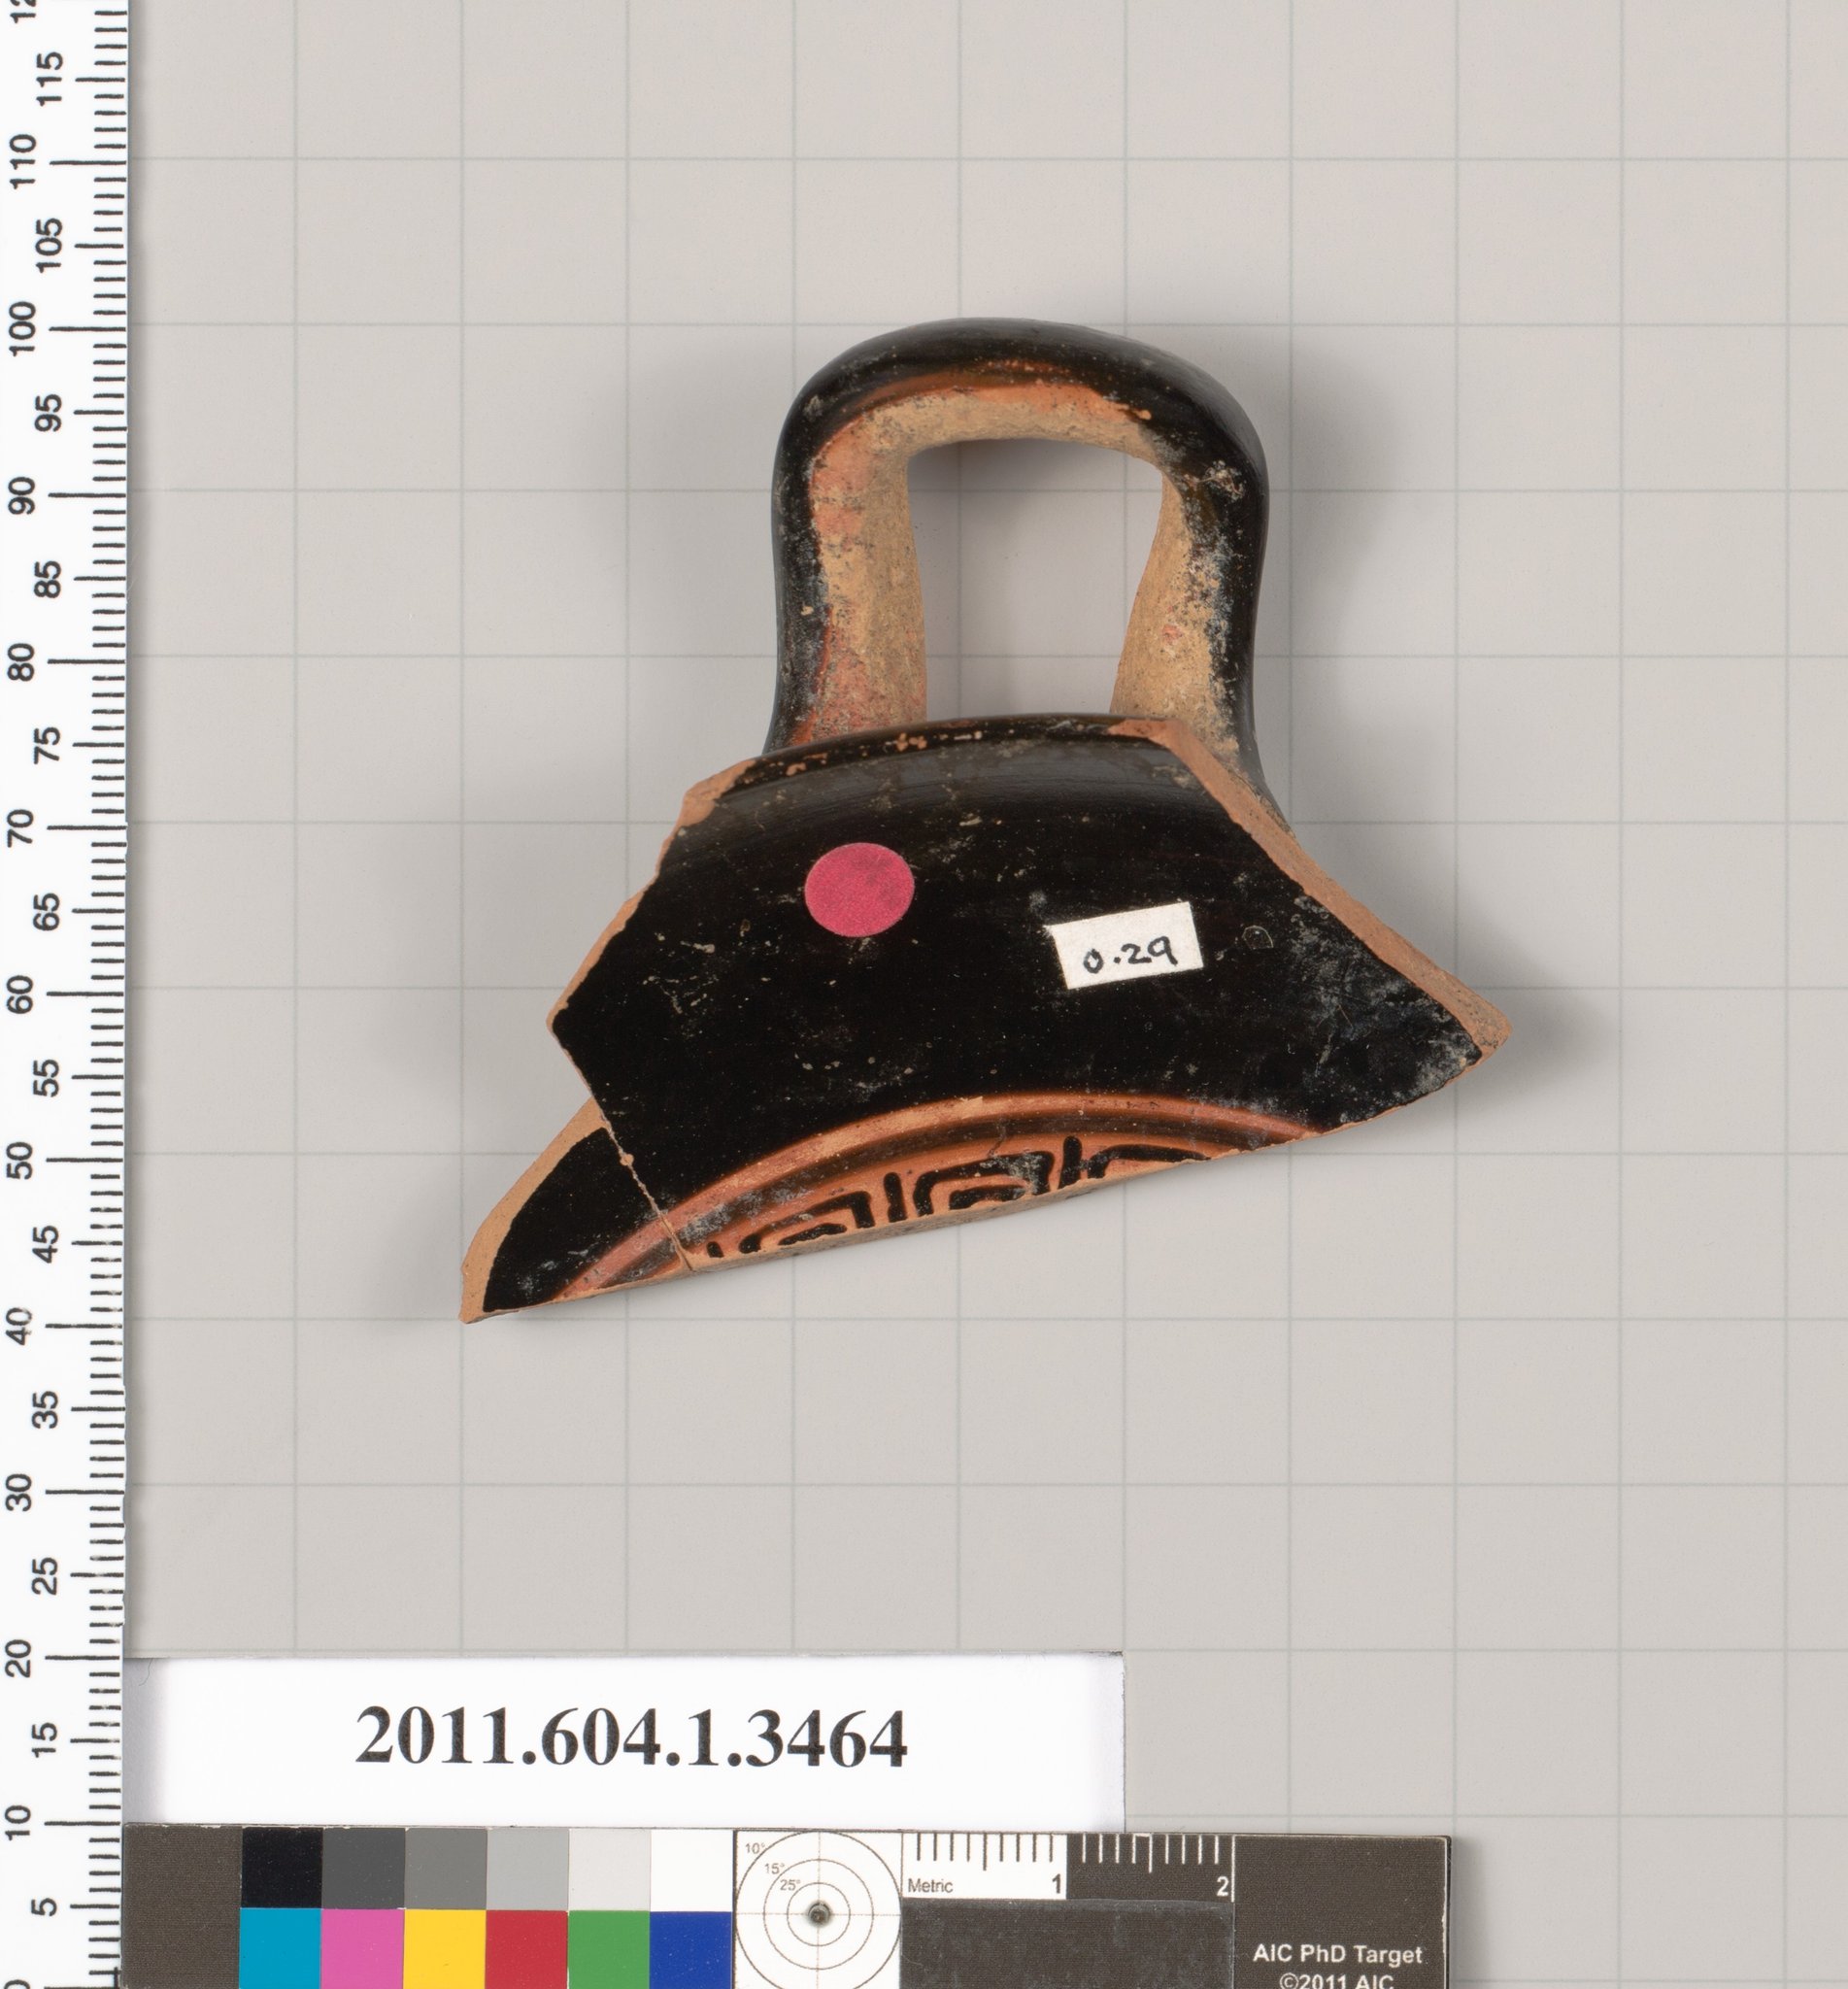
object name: kylix fragment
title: Terracotta fragment of a kylix (drinking cup)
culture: greek, attic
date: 500-476 BCE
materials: terracotta